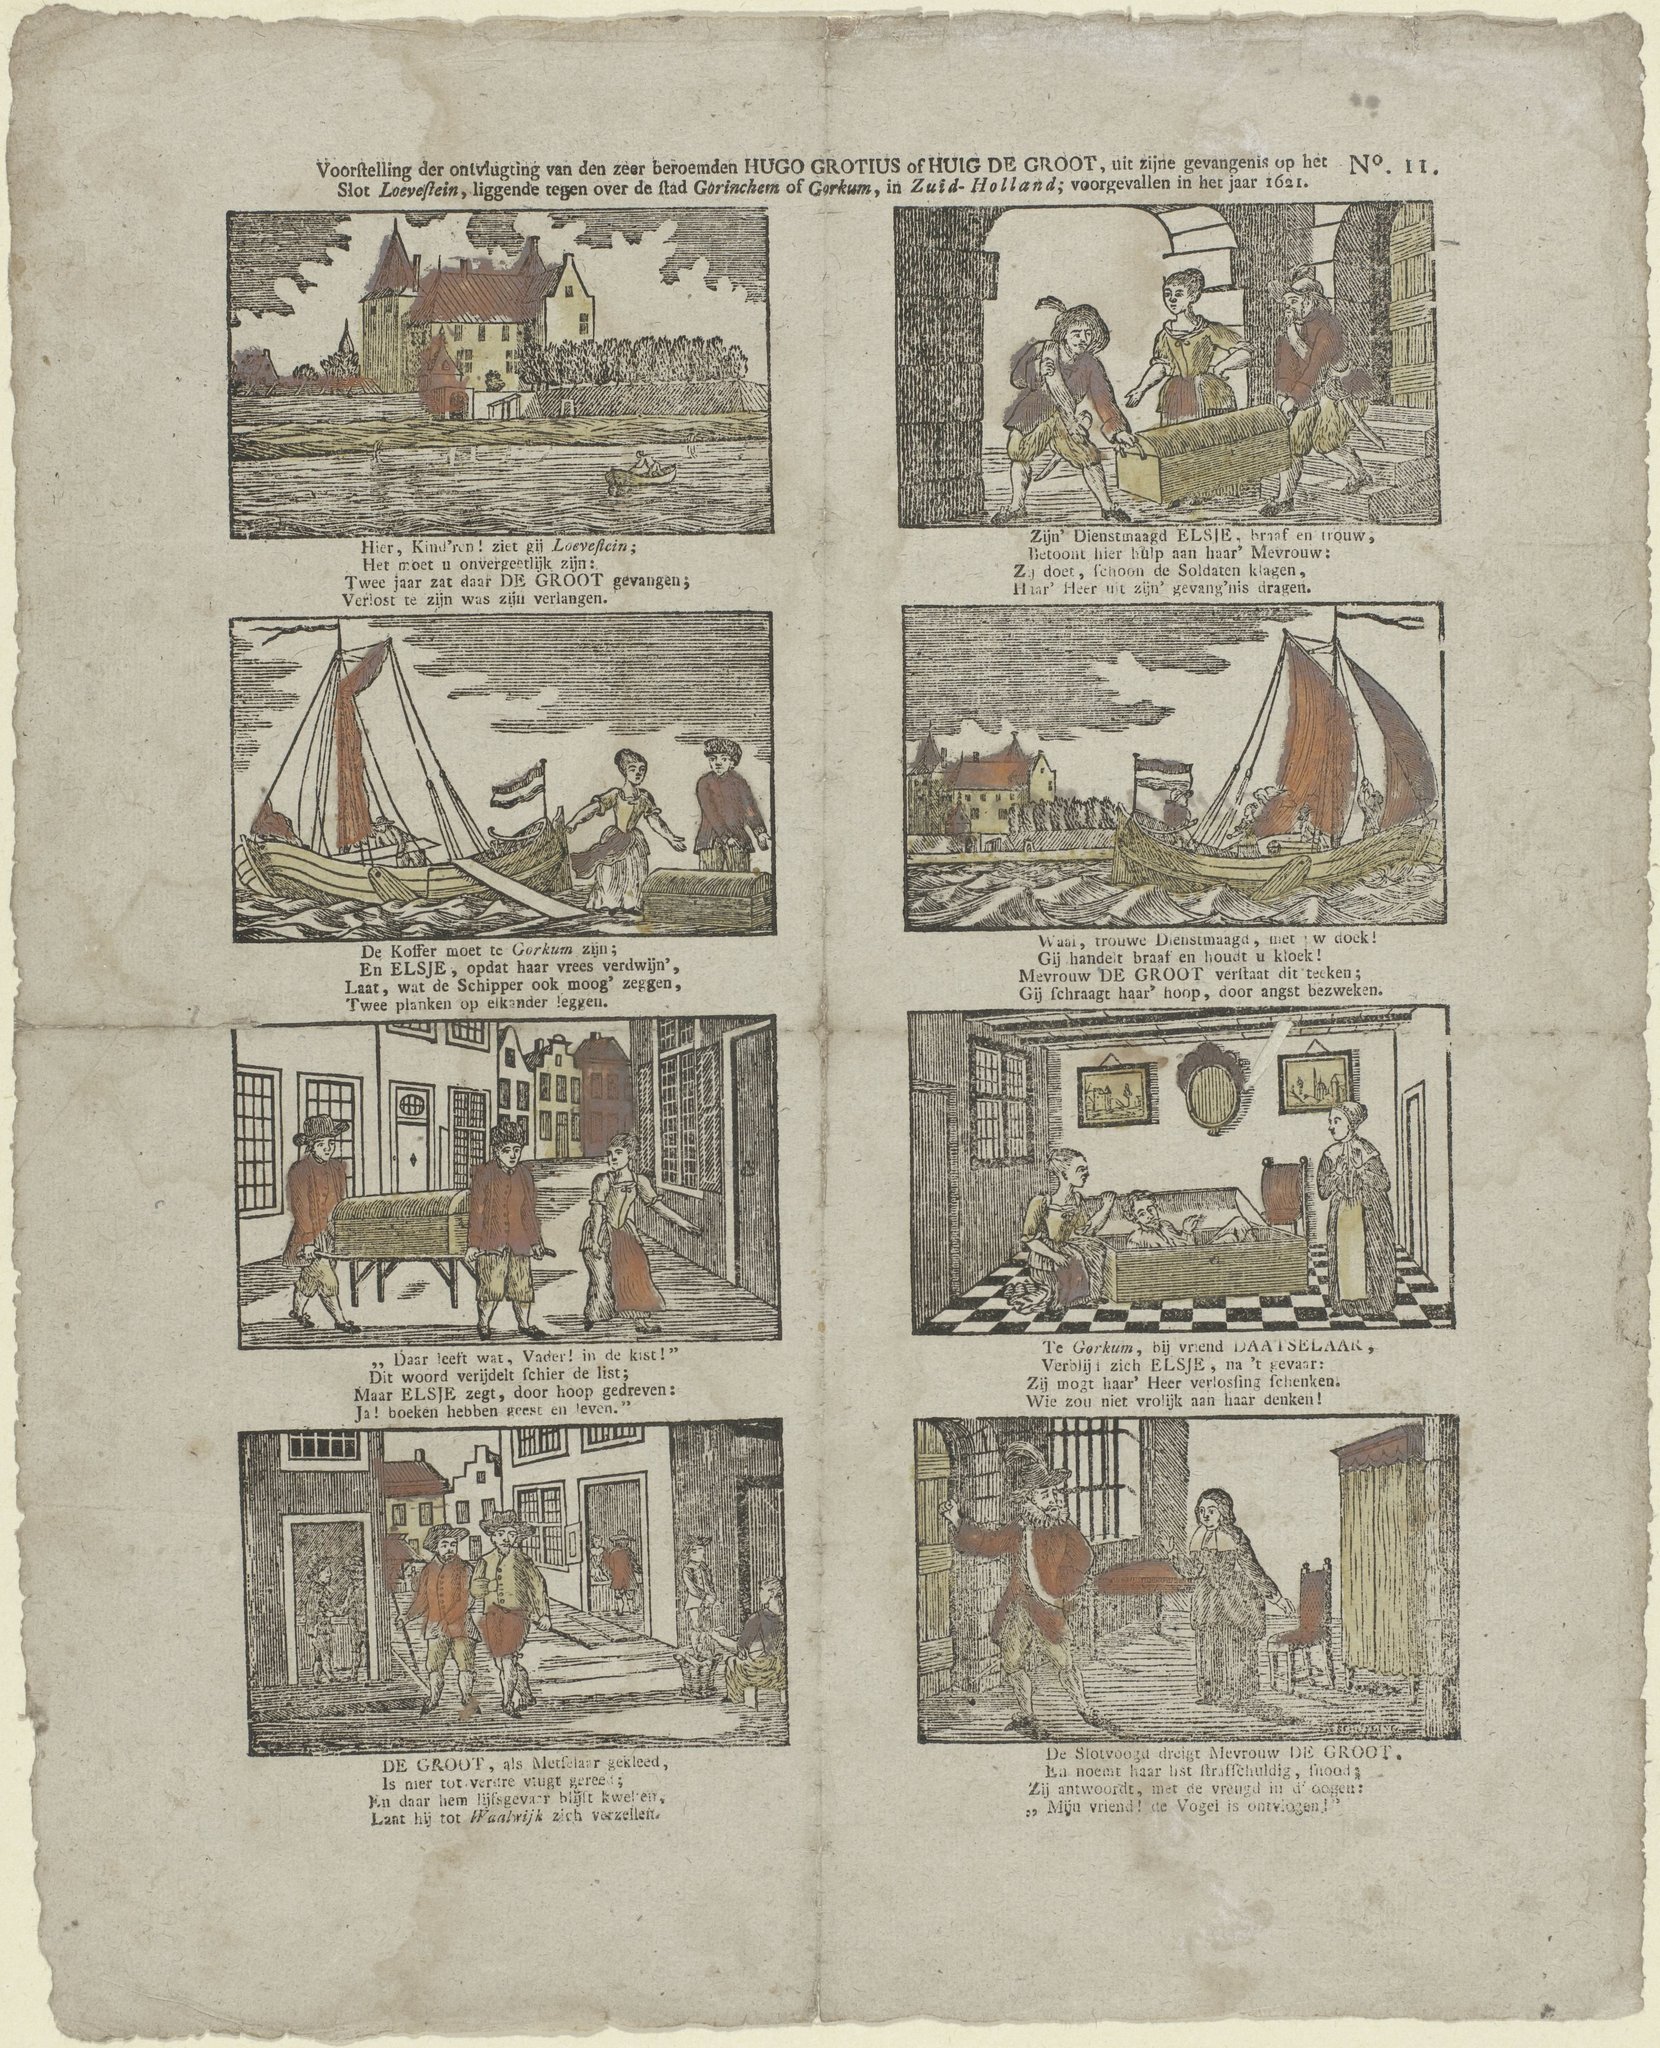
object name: print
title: Voorstelling der ontvlugting van den zeer beroemden Hugo Grotius of Hugo de Groot (...)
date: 1820-1838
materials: paper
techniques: colour, letterpress printing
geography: rotterdam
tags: delft, hugo de groot, escape, escape attempts, loevestein castle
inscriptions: collector's mark: Lugt 2760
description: Blad met 8 voorstellingen over de ontsnapping van Hugo de Groot uit Slot Loevestein. Onder elke afbeelding een vierregelig vers. Genummerd rechtsboven: No. 11.